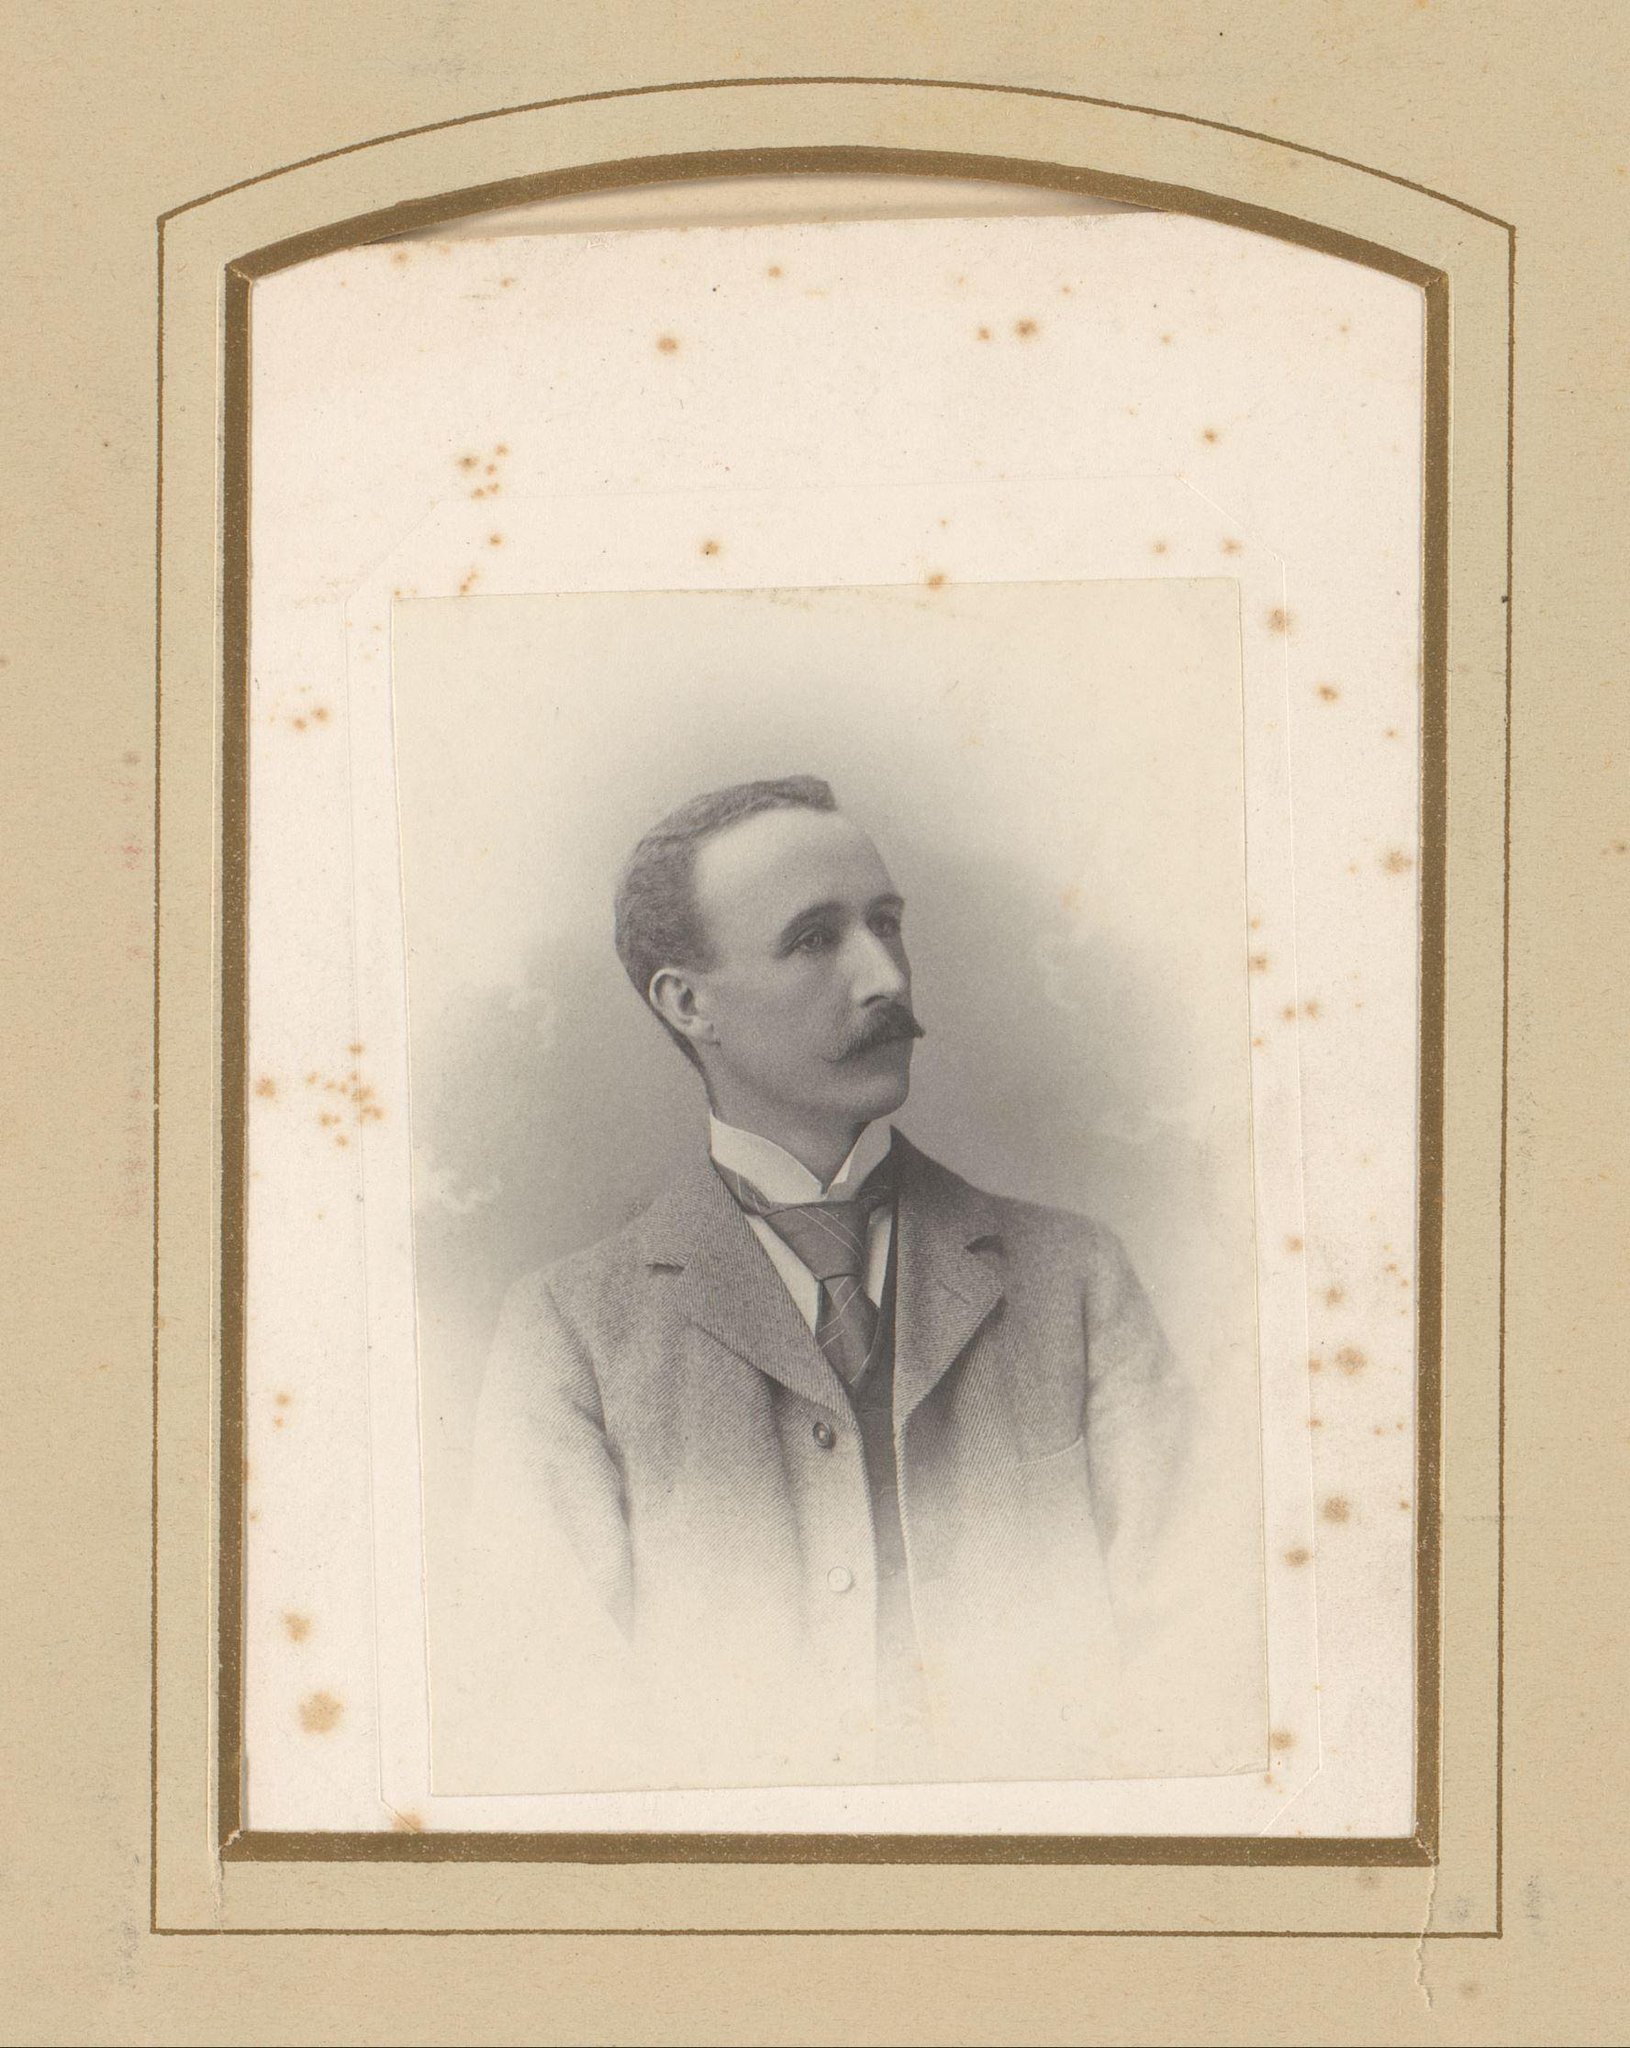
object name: cabinet photograph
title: Portret van een man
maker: harry john dalby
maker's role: fotograaf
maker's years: 1868-1902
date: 1897-1901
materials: cardboard, photographic support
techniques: platinum process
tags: moustache, adult man, anonymous historical persons portrayed in a group, in a group-portrait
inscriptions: inscription: ‘Dalby 82-83 Wellington St./ Woolwich’